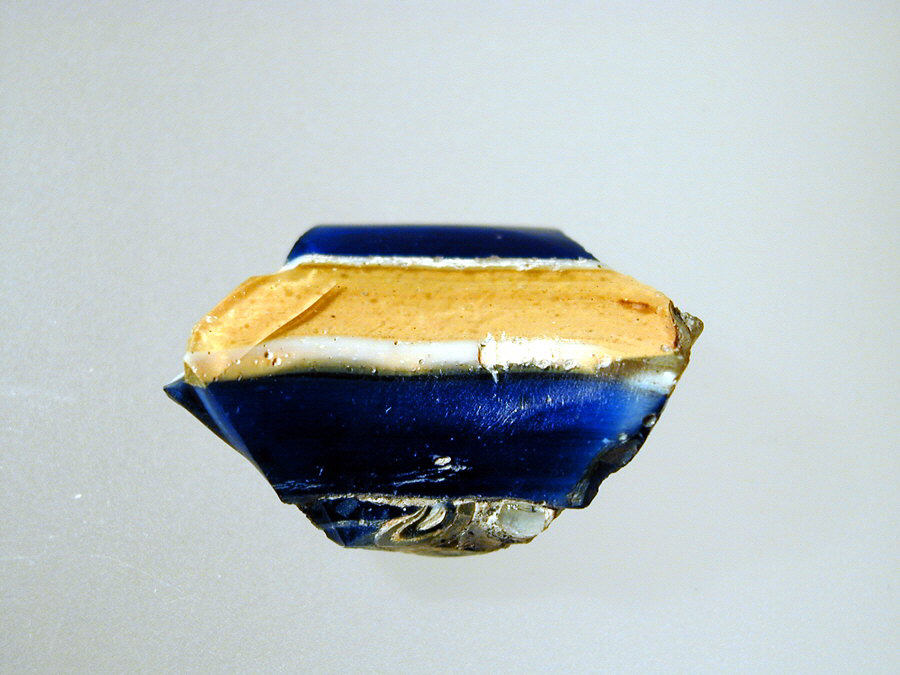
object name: fragment, ribbon mosaic base ring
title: Glass ribbon mosaic base fragment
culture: roman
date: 34 BCE-33 CE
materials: glass